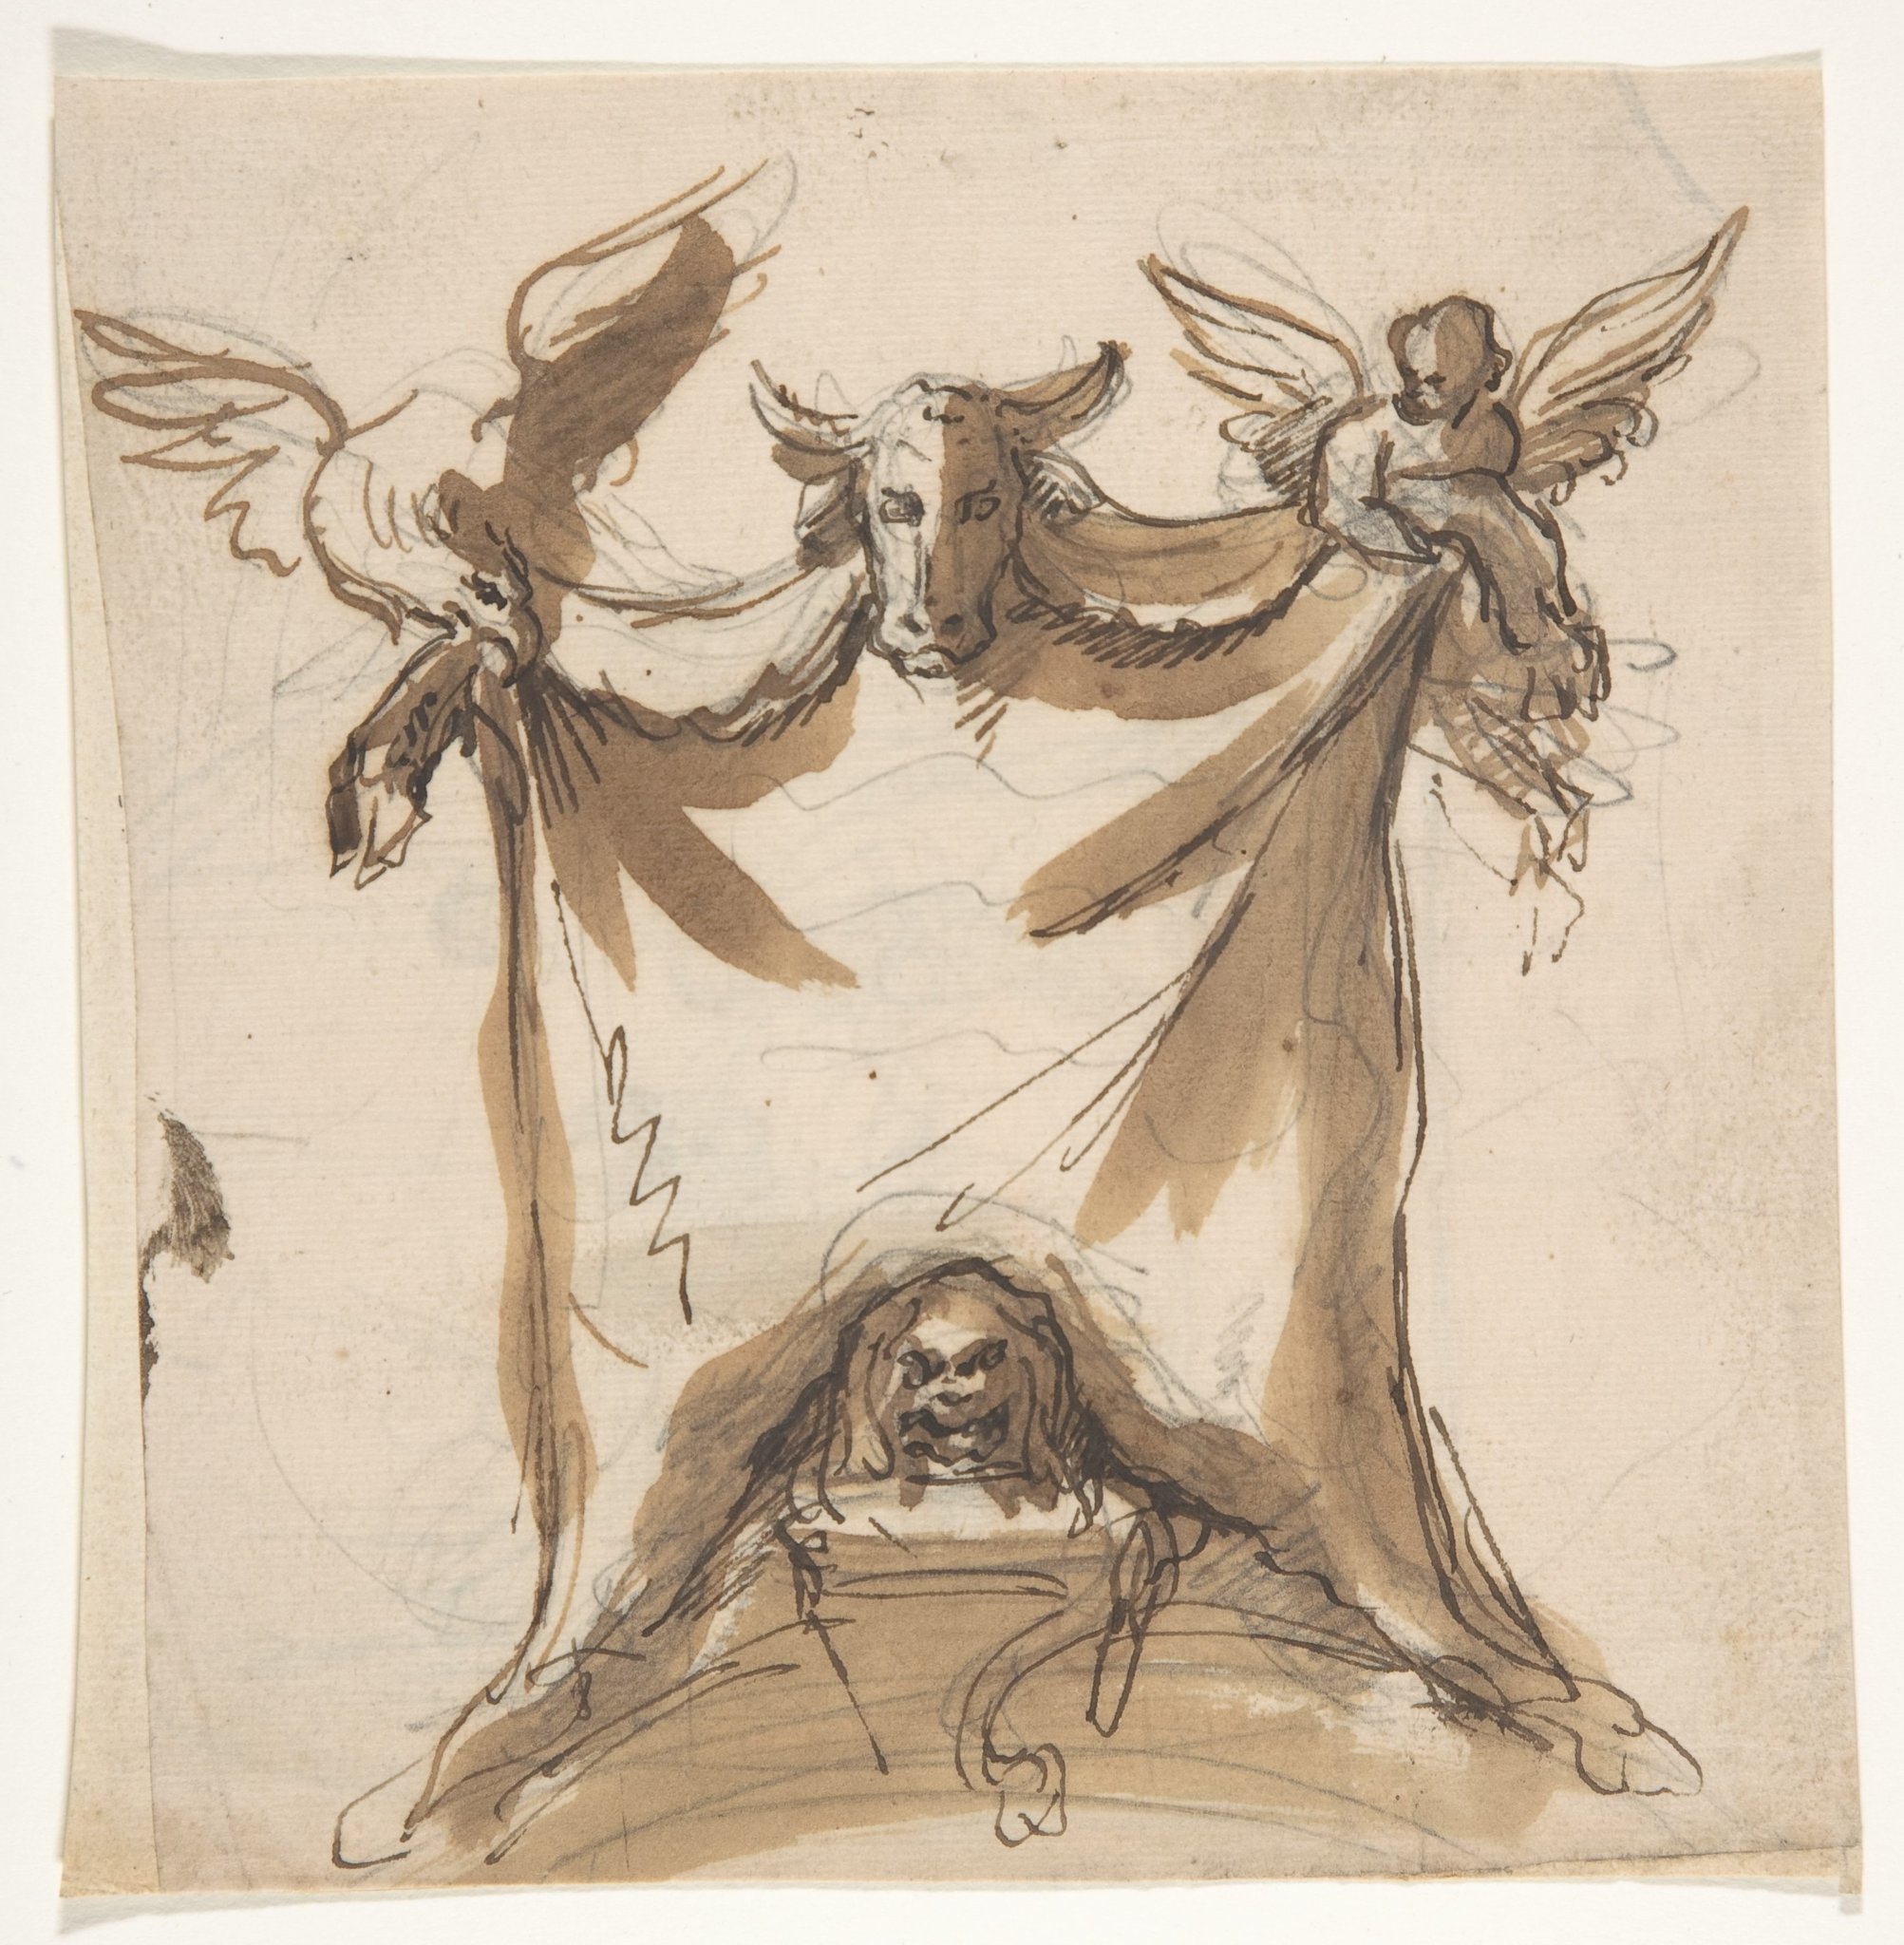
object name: drawing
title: Design for a monument (recto); Architectural sketches (verso)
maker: pieter verbruggen the younger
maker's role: artist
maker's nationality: flemish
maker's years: 1648-1691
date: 1667-1733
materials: chalk, graphite, ink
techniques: pen, wash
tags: animals,birds